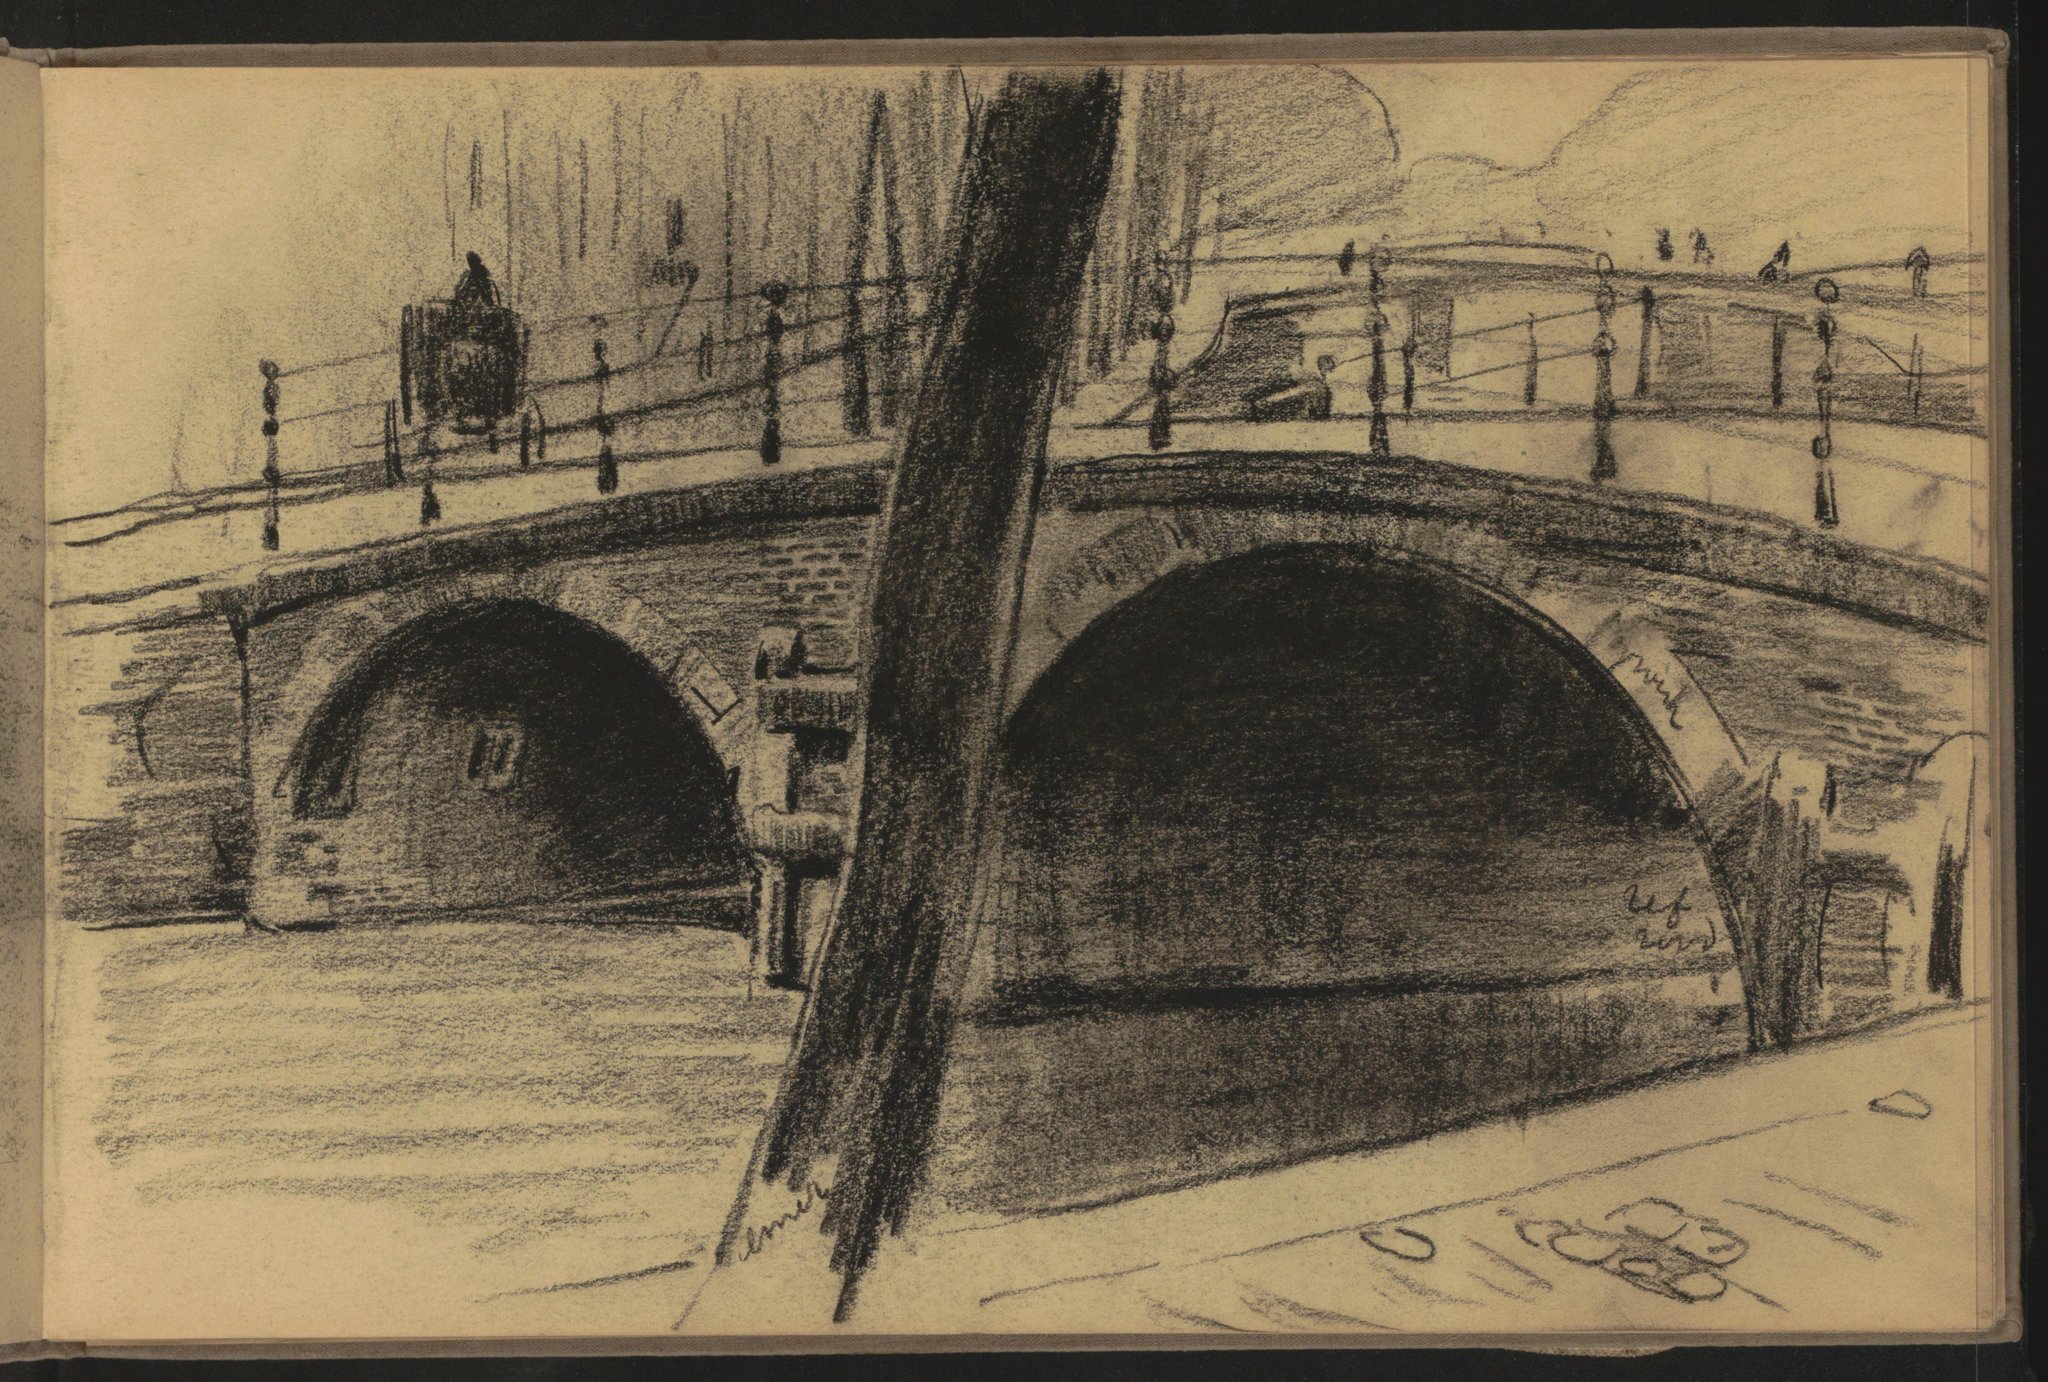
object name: sketchbook leaf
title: Brug over de Herengracht te Amsterdam, ter hoogte van de Leidsegracht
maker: willem witsen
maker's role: draughtsman, painter, print maker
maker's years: 1860-1923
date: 1901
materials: chalk, paper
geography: amsterdam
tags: trees, bridge in city across river, canal, etc.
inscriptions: kleurnotitie, handgeschreven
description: Voorstudie voor de ets 'Herengracht', ca. 1901.